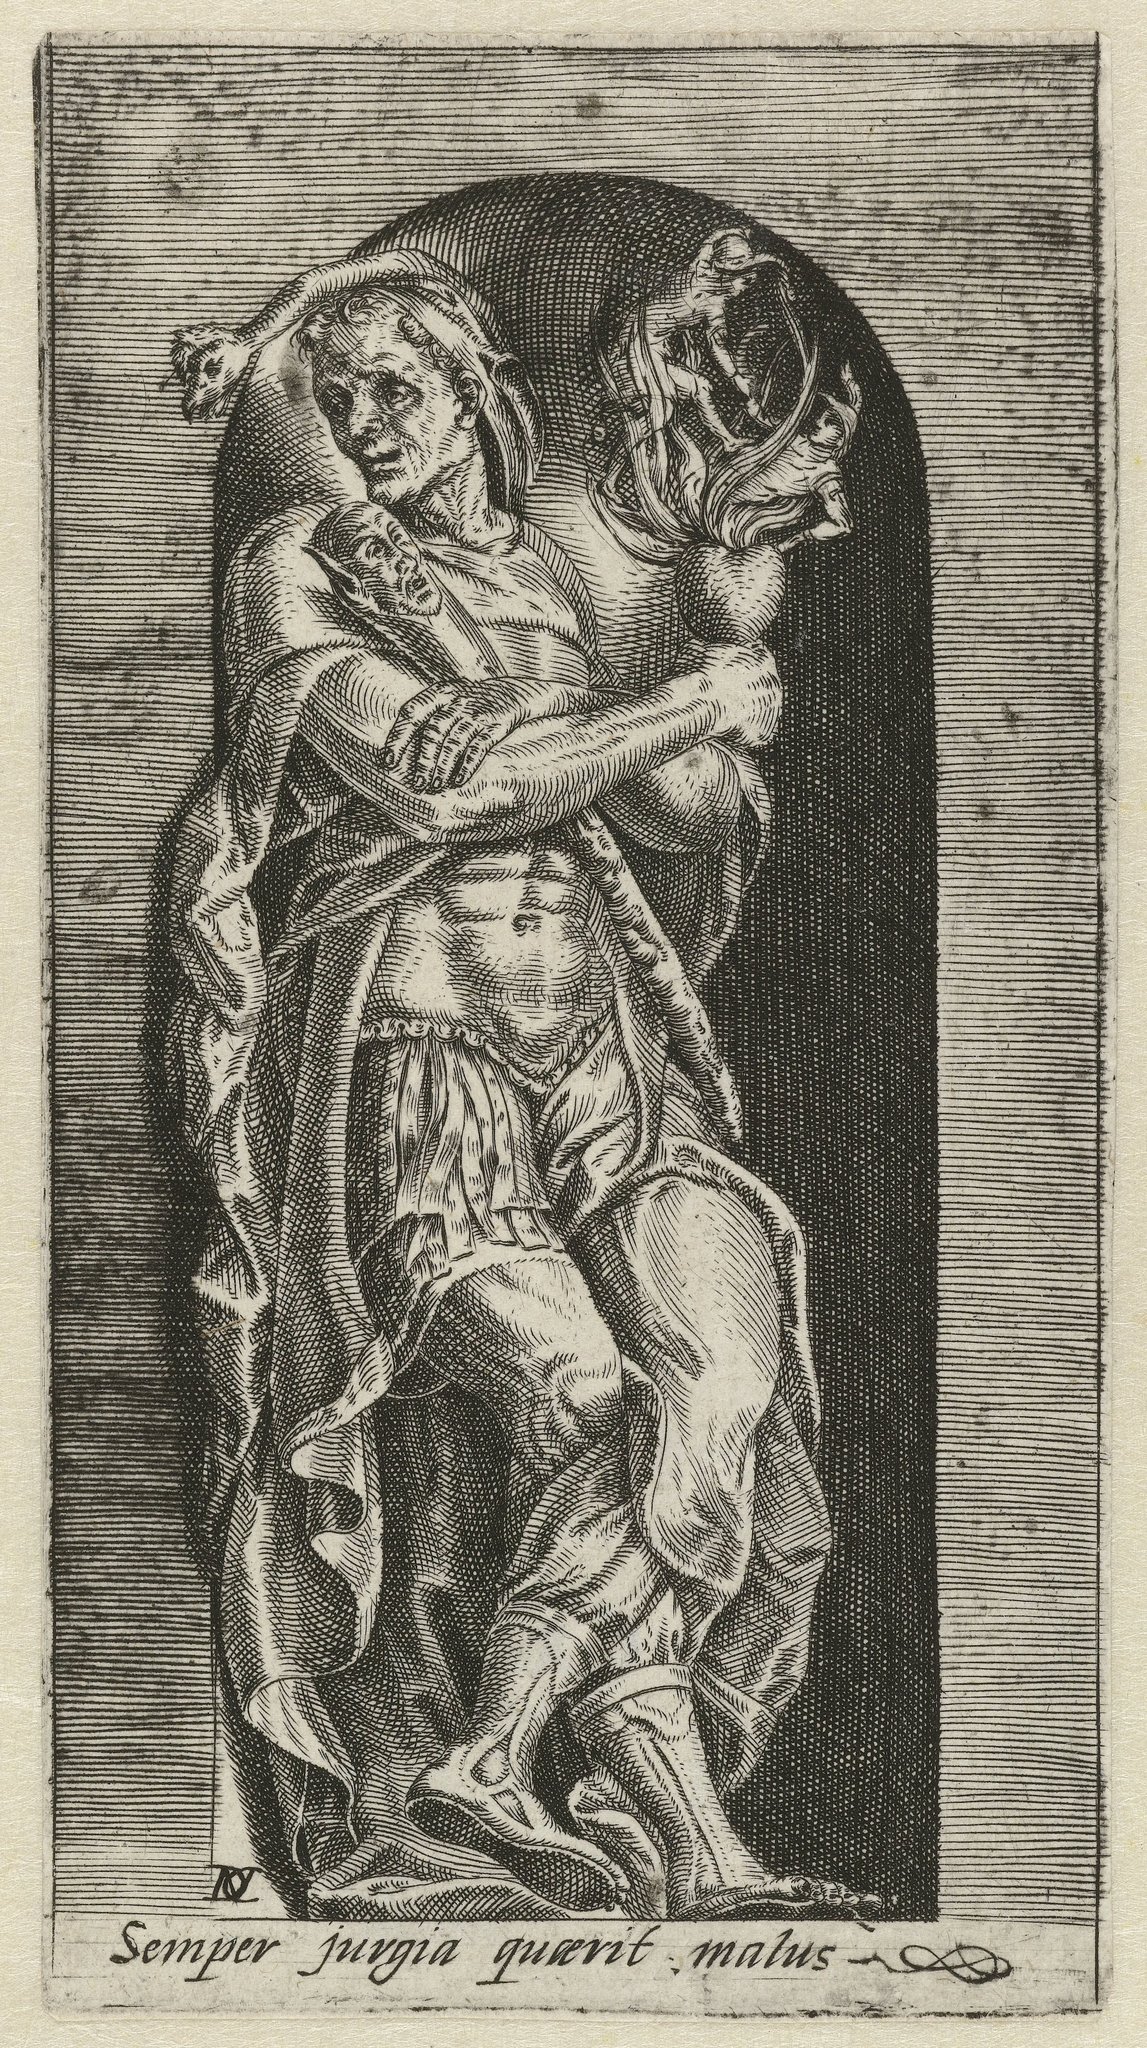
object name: print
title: Dwaasheid van tweedracht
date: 1532-1590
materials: paper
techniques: engraving, etching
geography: haarlem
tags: fool, simpleton, numskull, disagreement, discord; 'discordia' (ripa), heart symbolism (+ fighting)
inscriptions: collector's mark: Lugt 2228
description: Een zot in Romeinse wapenrusting leunt tegen een nis. Hij houdt een brandend menselijk hart vast. In de vlammen zijn twee mannen in een gevecht verwikkeld. De prent heeft een Latijns onderschrift dat waarschuwt voor de gevaren van twist (Spreuken 17:11a).